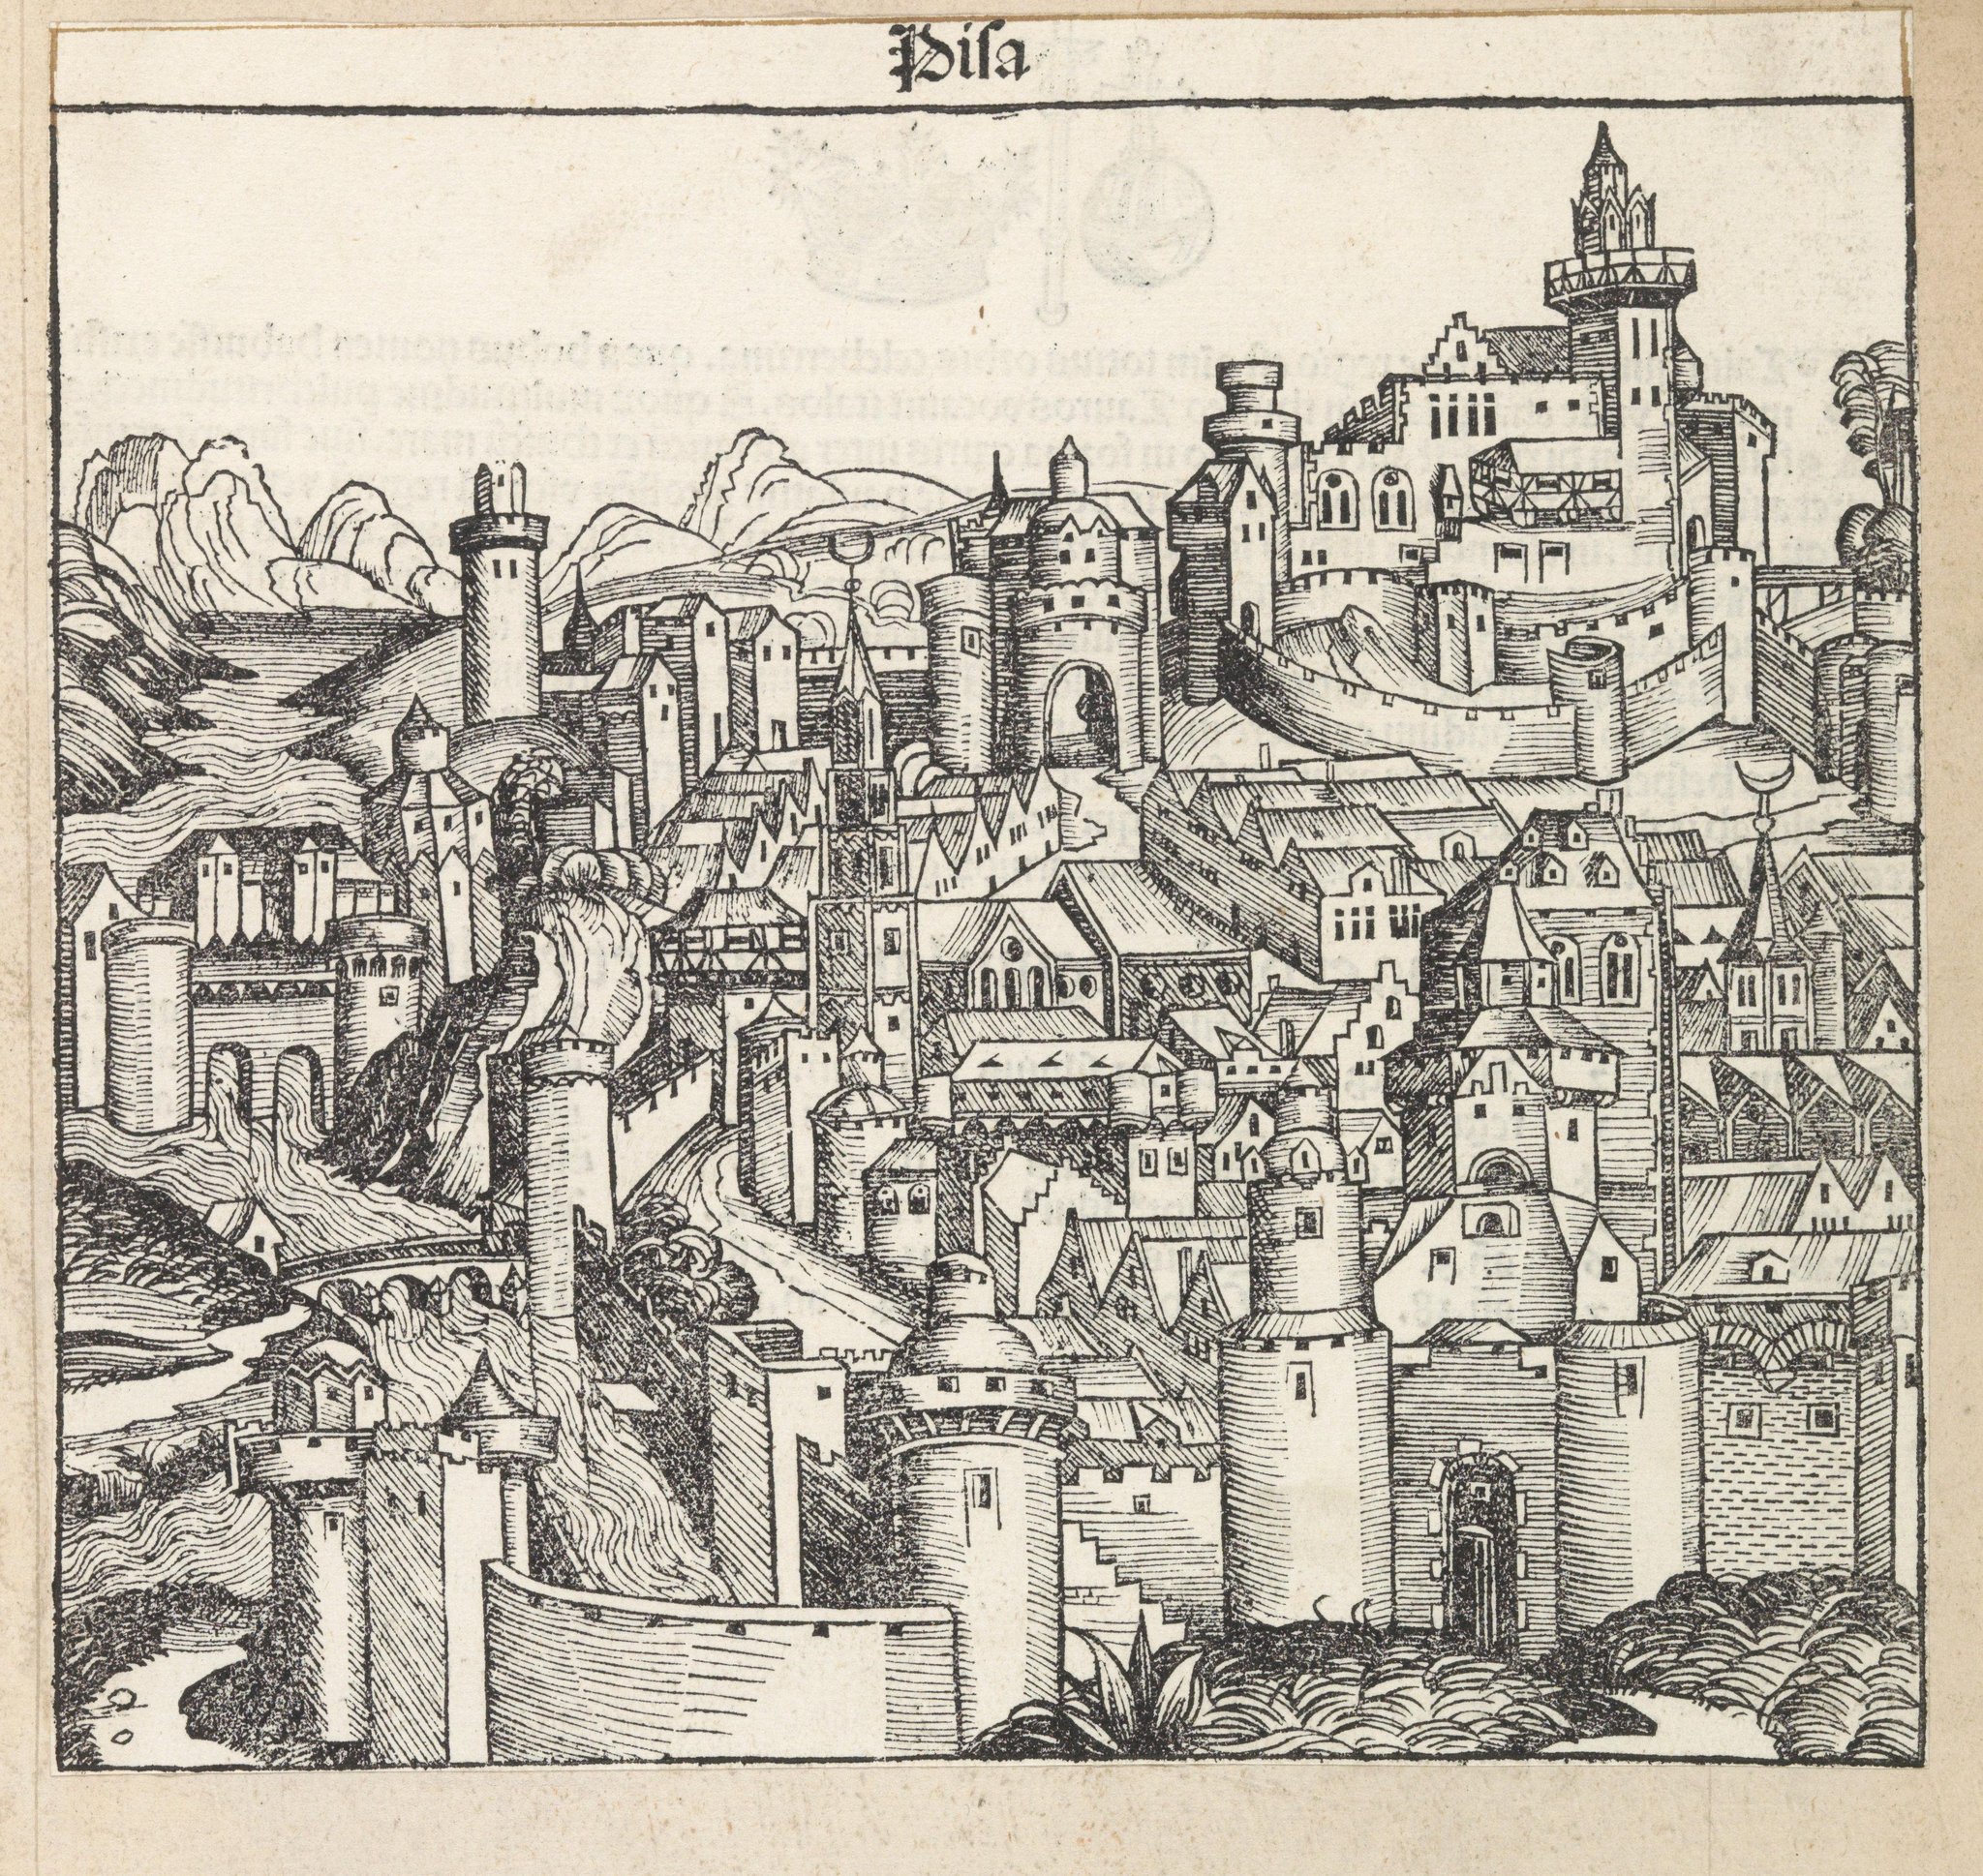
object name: pastedown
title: Gezicht op Pisa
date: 1493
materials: paper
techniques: letterpress printing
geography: nuremberg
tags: city-view, and landscape with man-made constructions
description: De houtsnede wordt herhaaldelijk gebruikt als boekillustratie in de Liber Chronicarum (of Neurenbergkroniek) van Hartmann Schedel, verschenen in het Latijn en Duits in 1493. Zie de Latijnse uitgave, folio 45v.